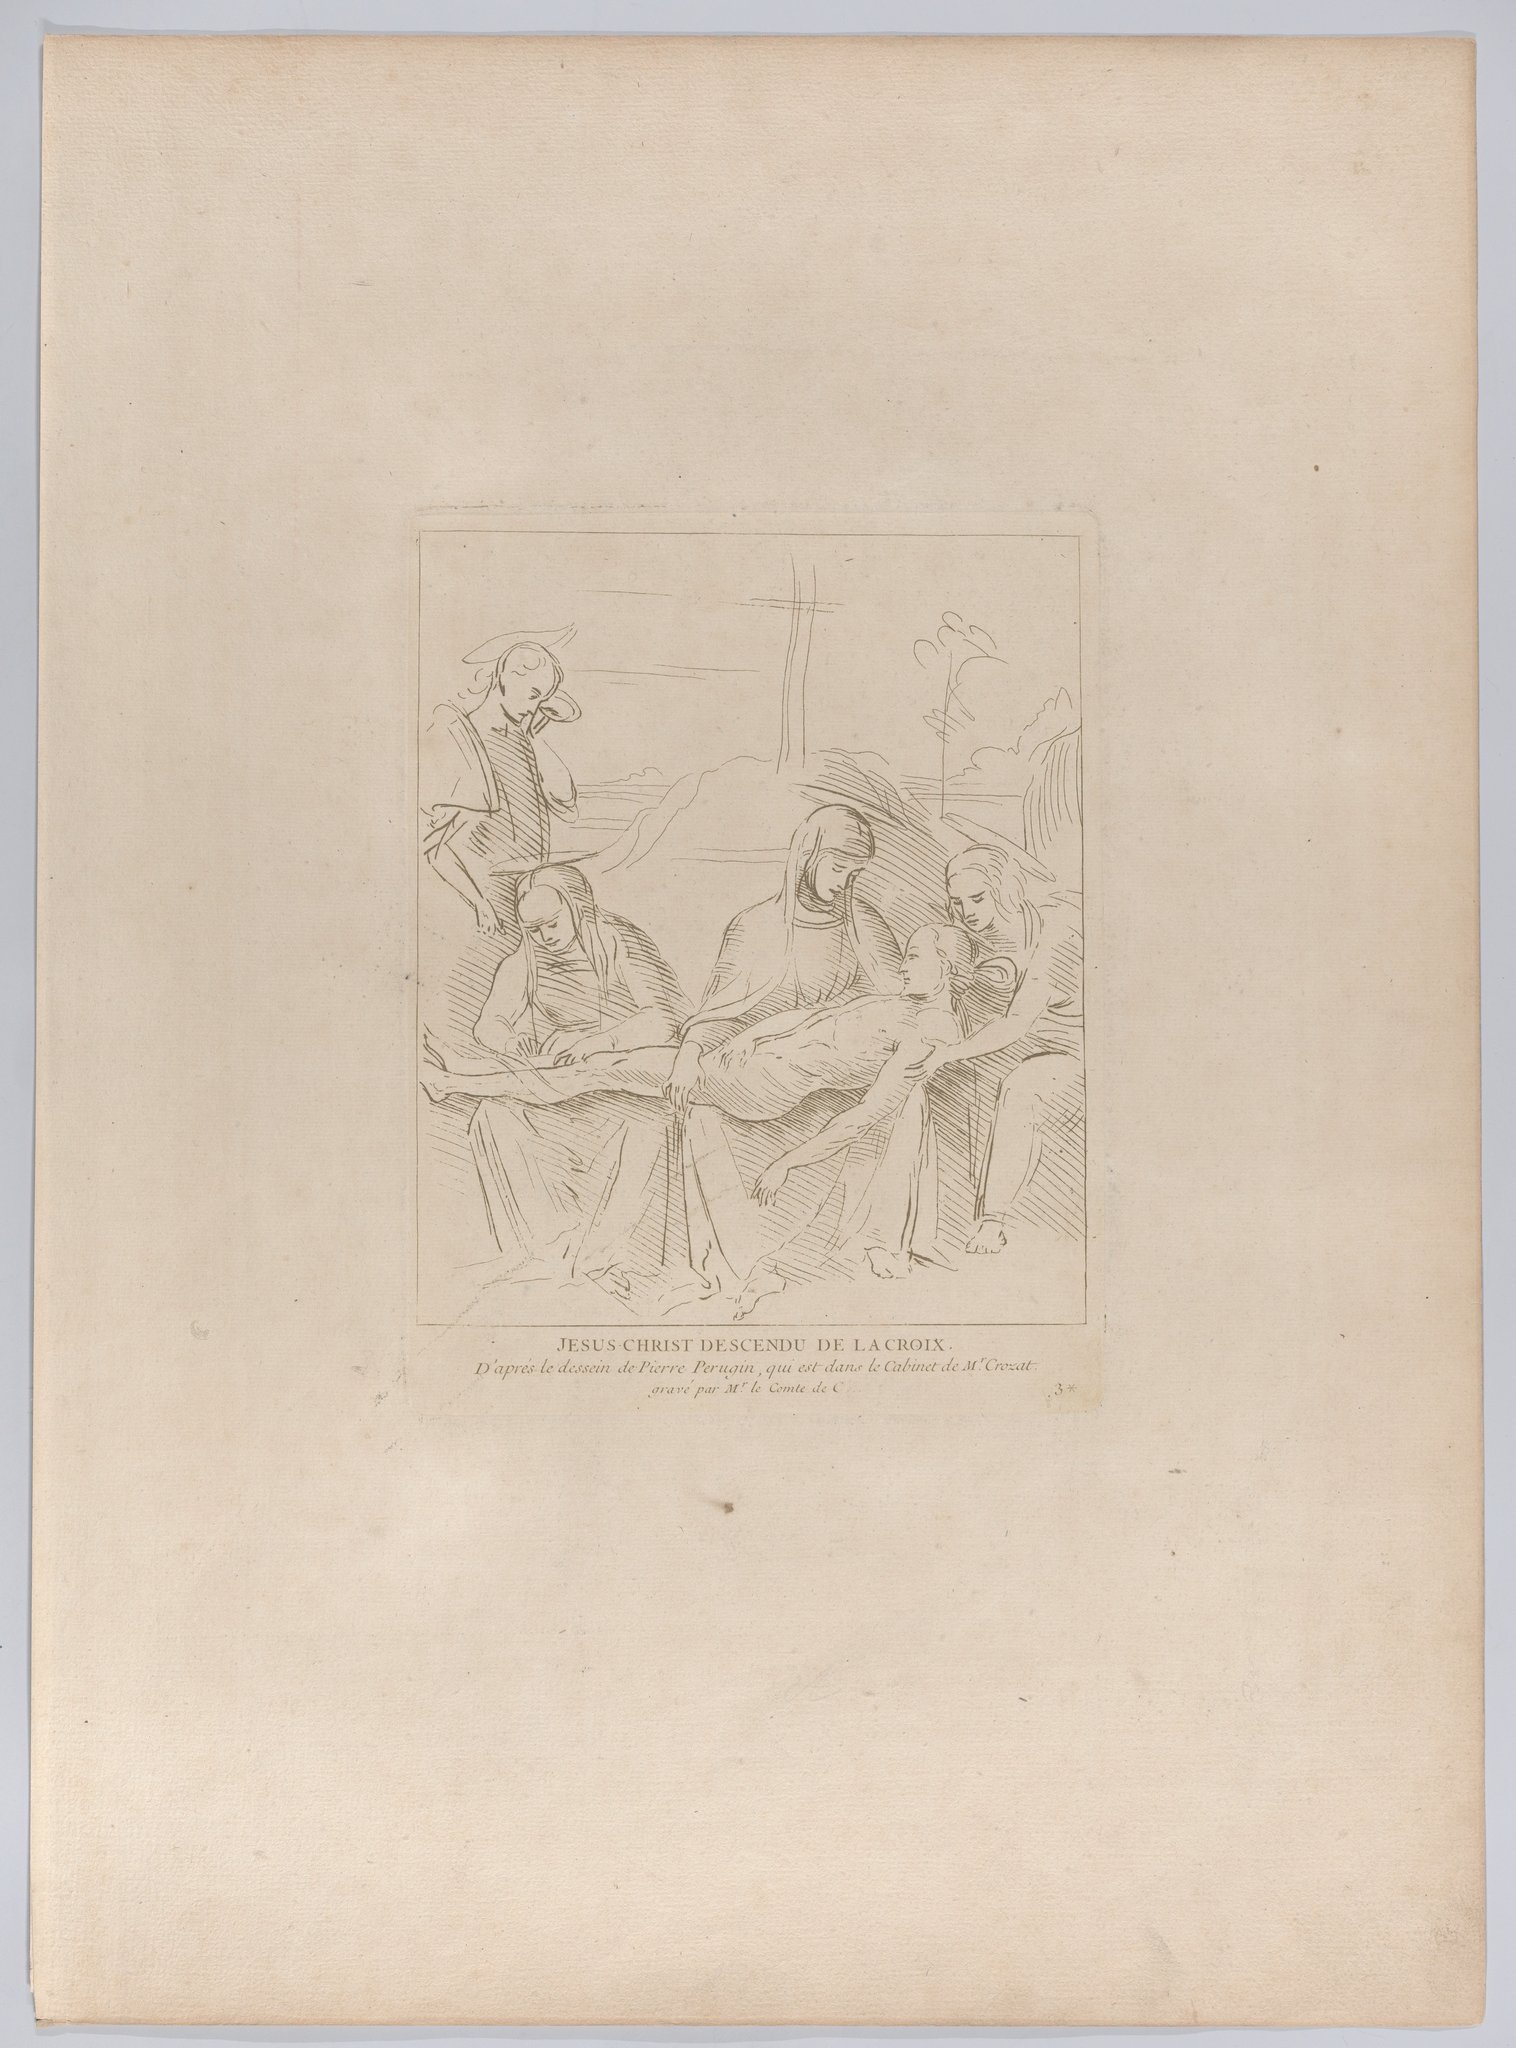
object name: print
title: Pietà, with the body of Christ supported by the Virgin and two holy women, Saint John stands to the left; from "Recueil d'estampes d'après les plus beaux tableaux et d'après les plus beaux desseins qui sont en France, Cabinet Crozat" after a drawing by Perugino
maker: anne claude philippe de tubières, comte de caylus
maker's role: artist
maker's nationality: french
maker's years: 1692-1765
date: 1729-1740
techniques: etching, printing